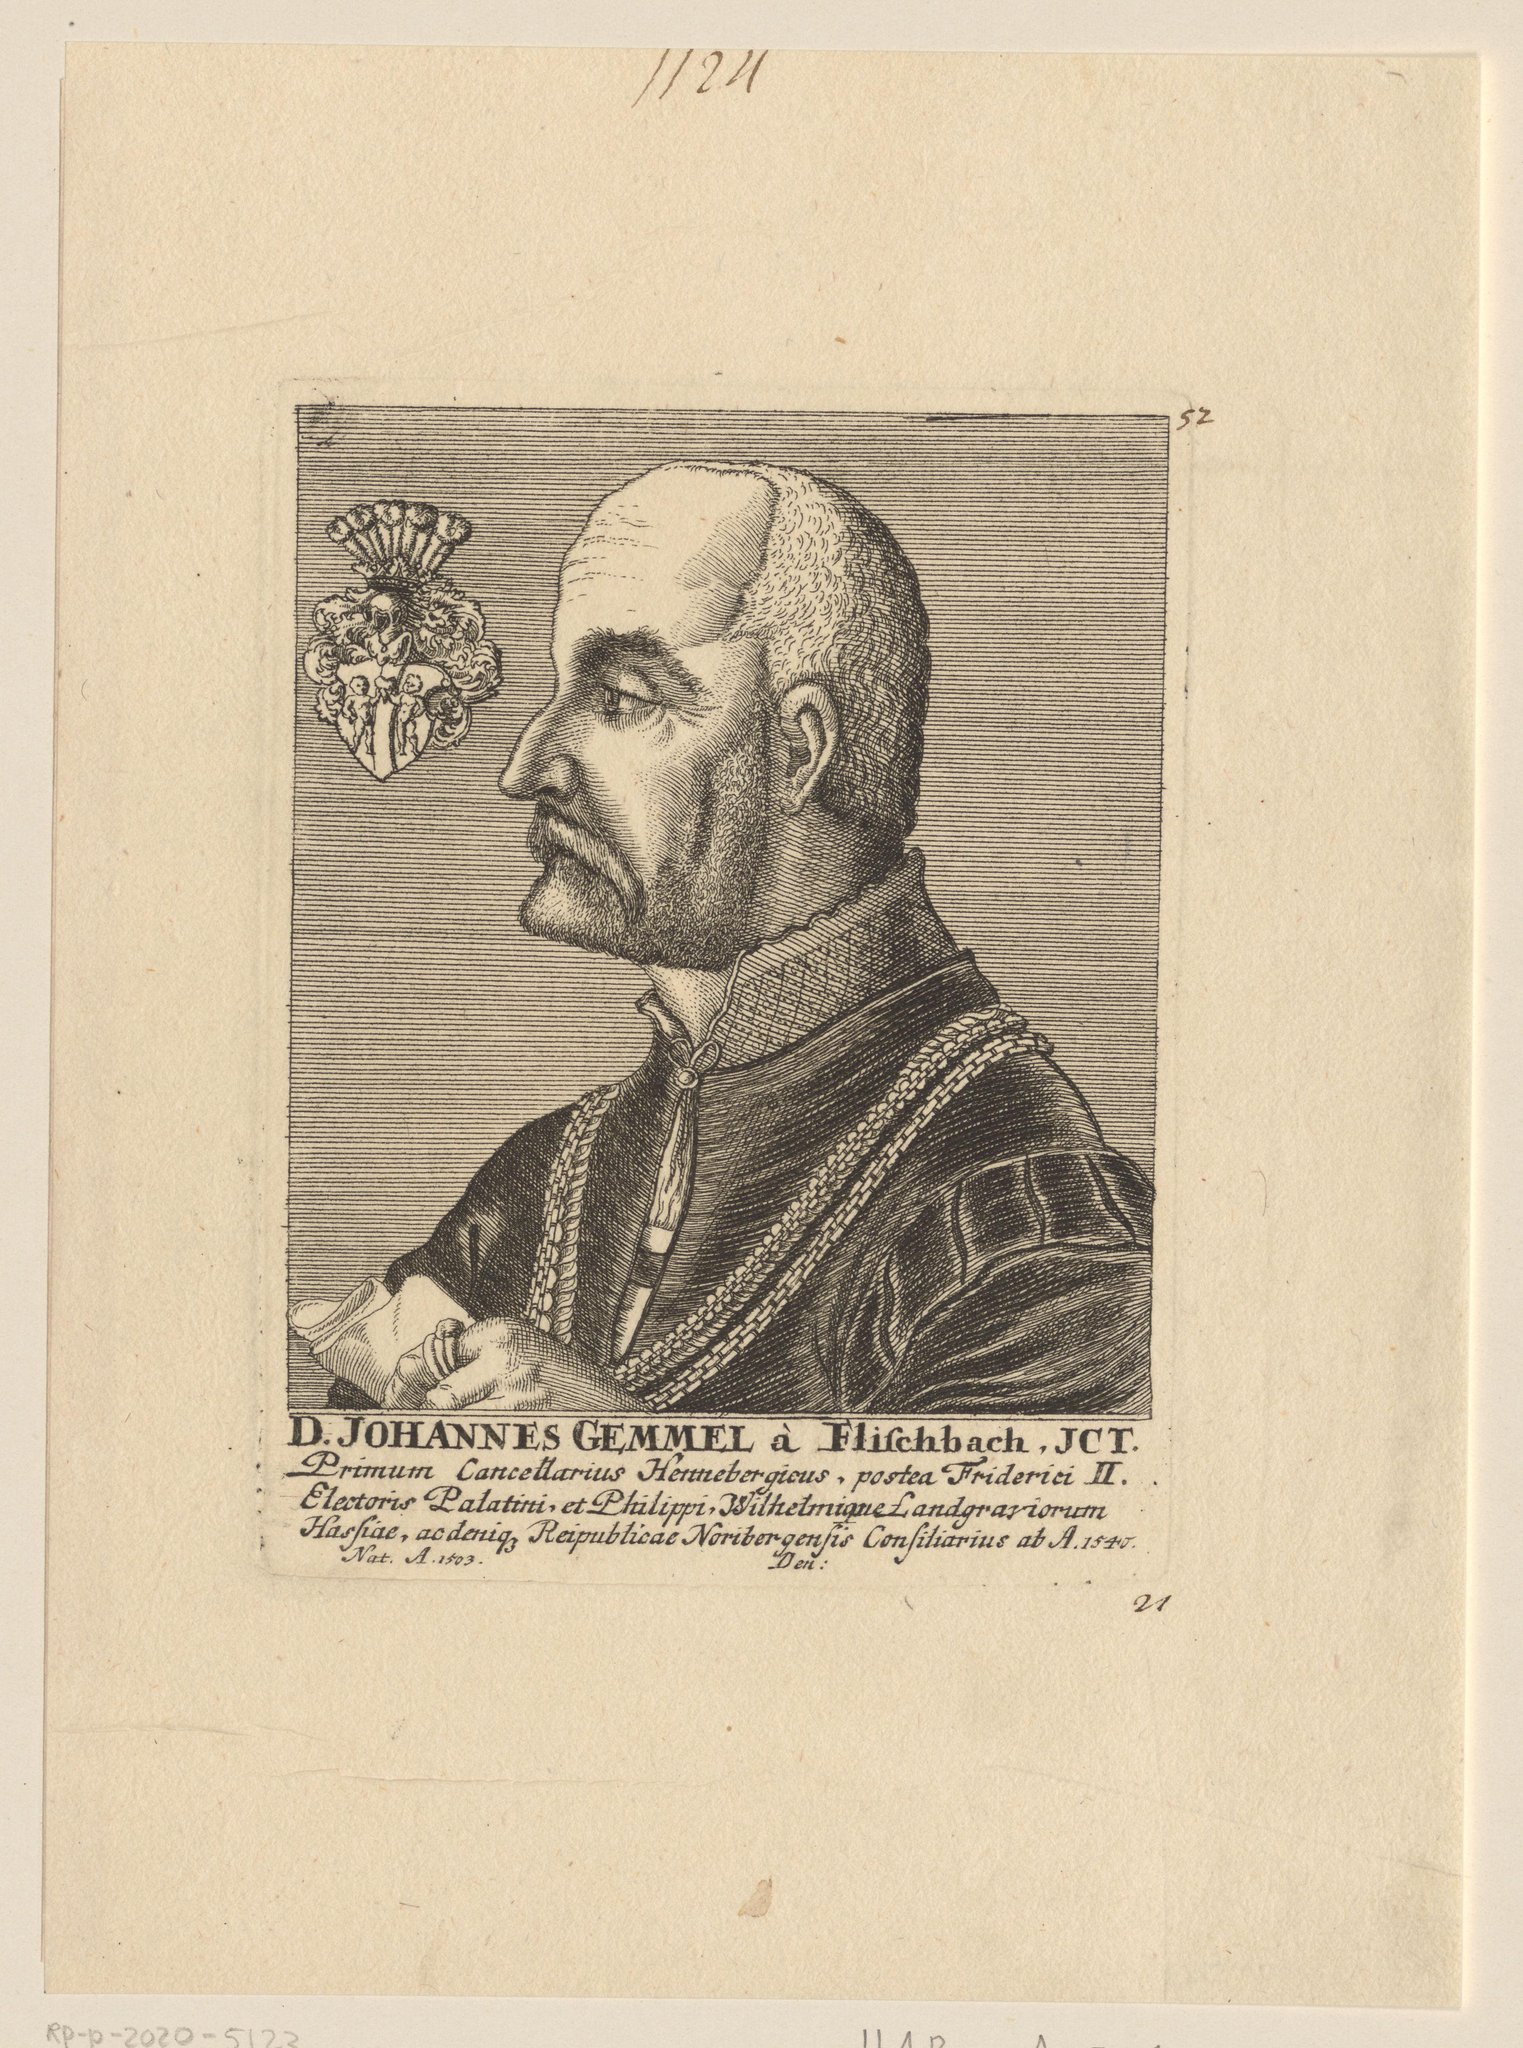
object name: print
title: Portret van Johann Gemmel op 51-jarige leeftijd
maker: georg wolfgang knorr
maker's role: print maker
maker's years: 1705-1761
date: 1540-1552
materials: paper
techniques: engraving, etching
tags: politician, historical persons, politician, e.g. party leader